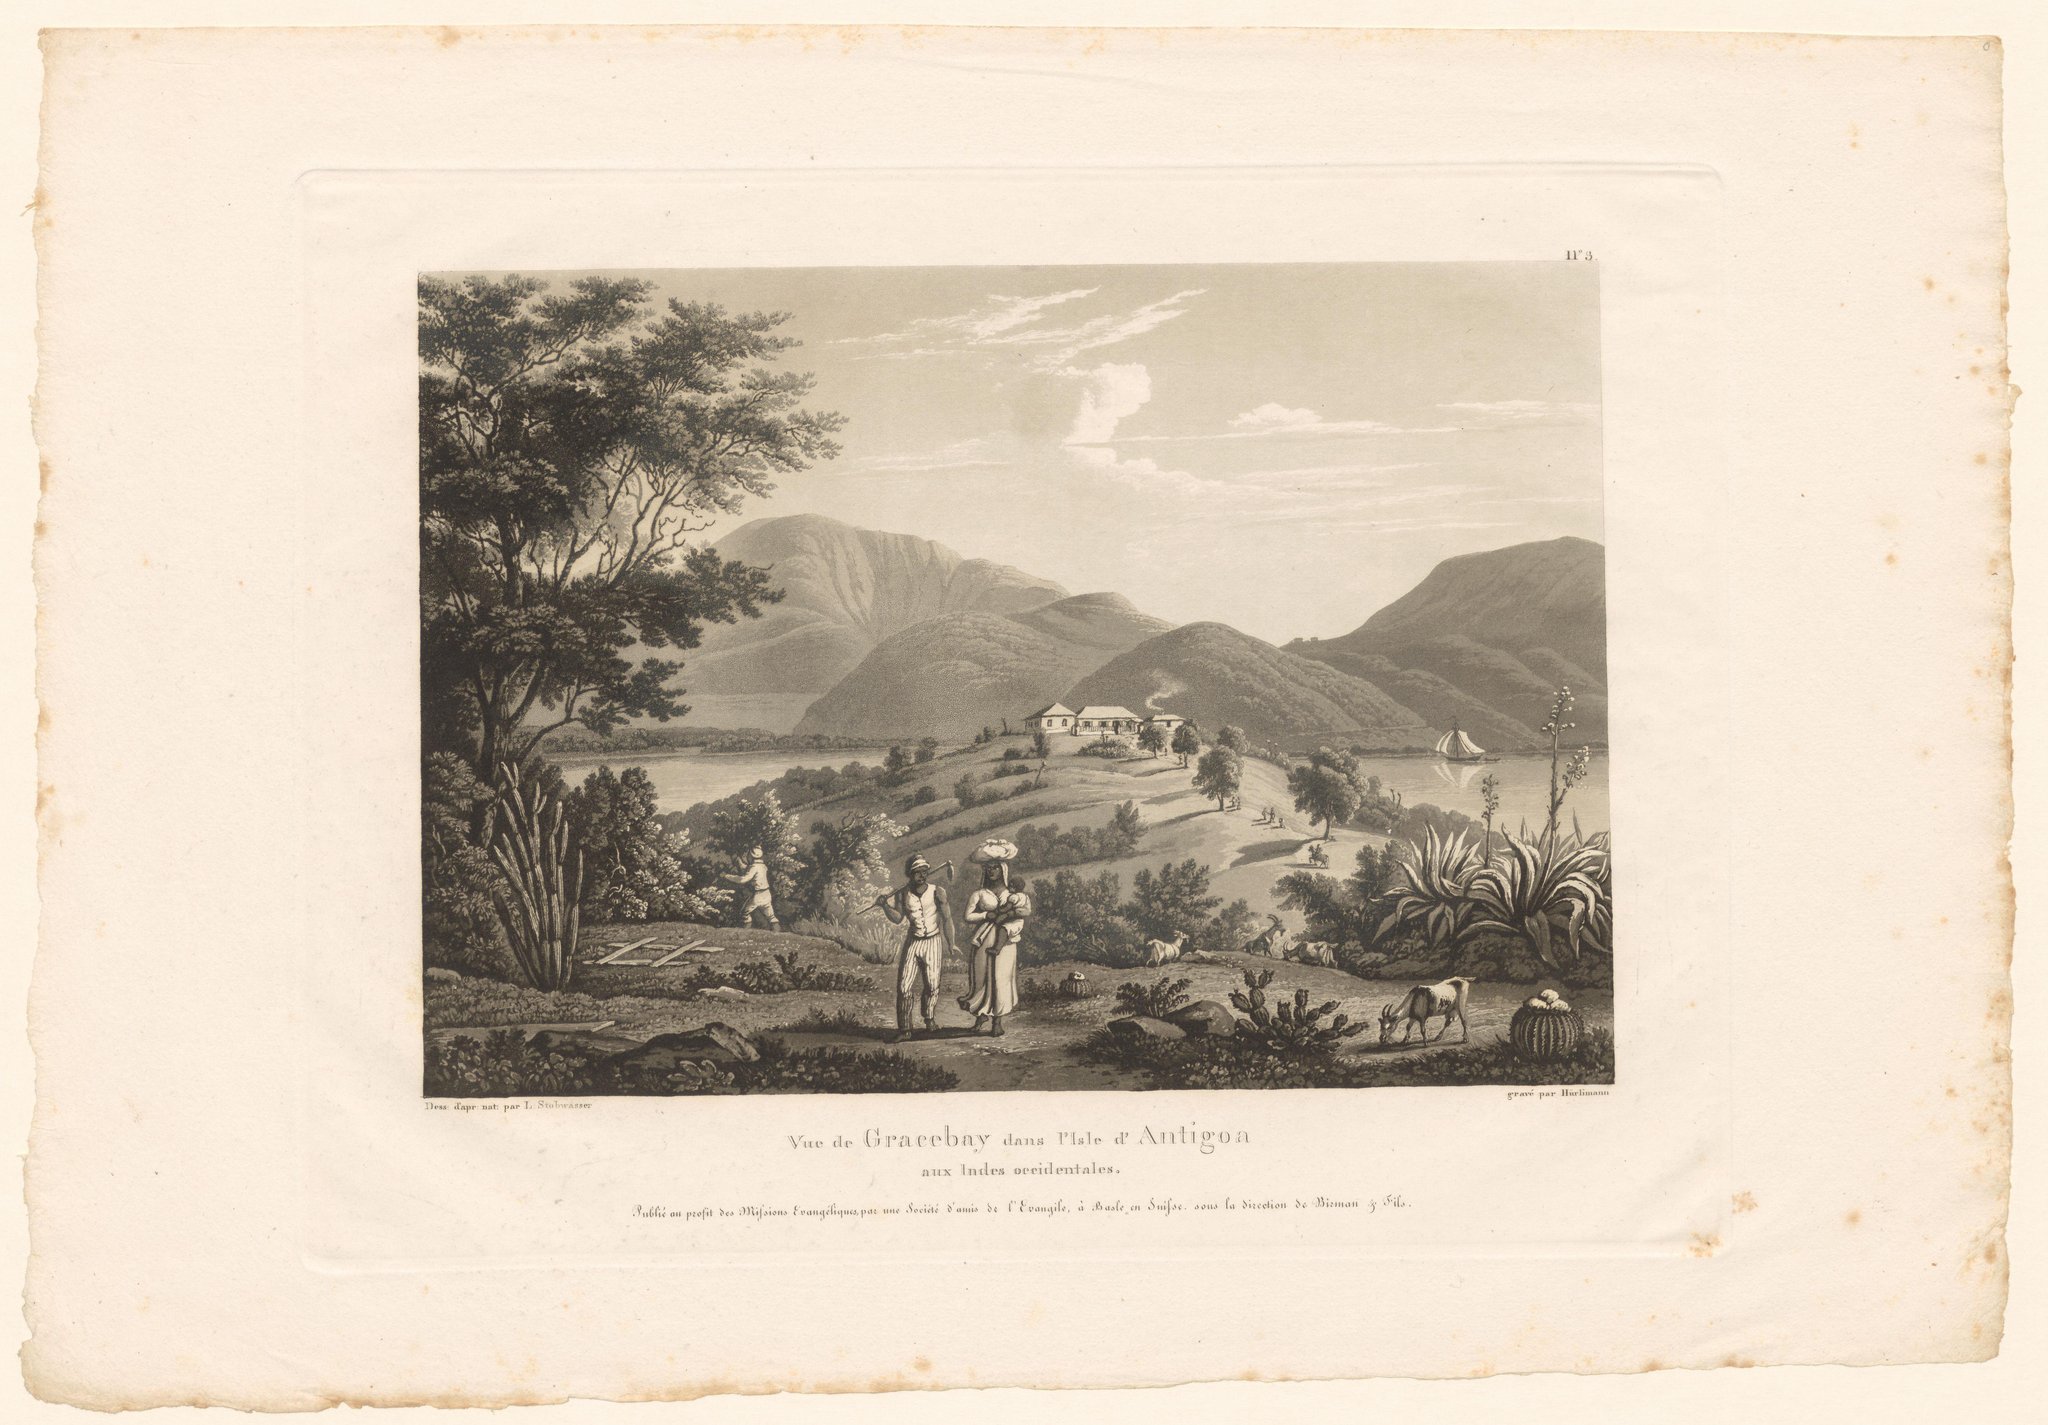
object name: print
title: Gezicht op de baai van het eiland Antigua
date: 1803-1850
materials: paper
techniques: aquatint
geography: basel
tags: gulf, bay - hh - ideal landscapes, agriculture, goat, mountains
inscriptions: number: ‘3’, collector's mark: Lugt 2228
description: Gepubliceerd door de Zwisterse uitgever Birmann & Fils ten behoeve van de evangelische missies.